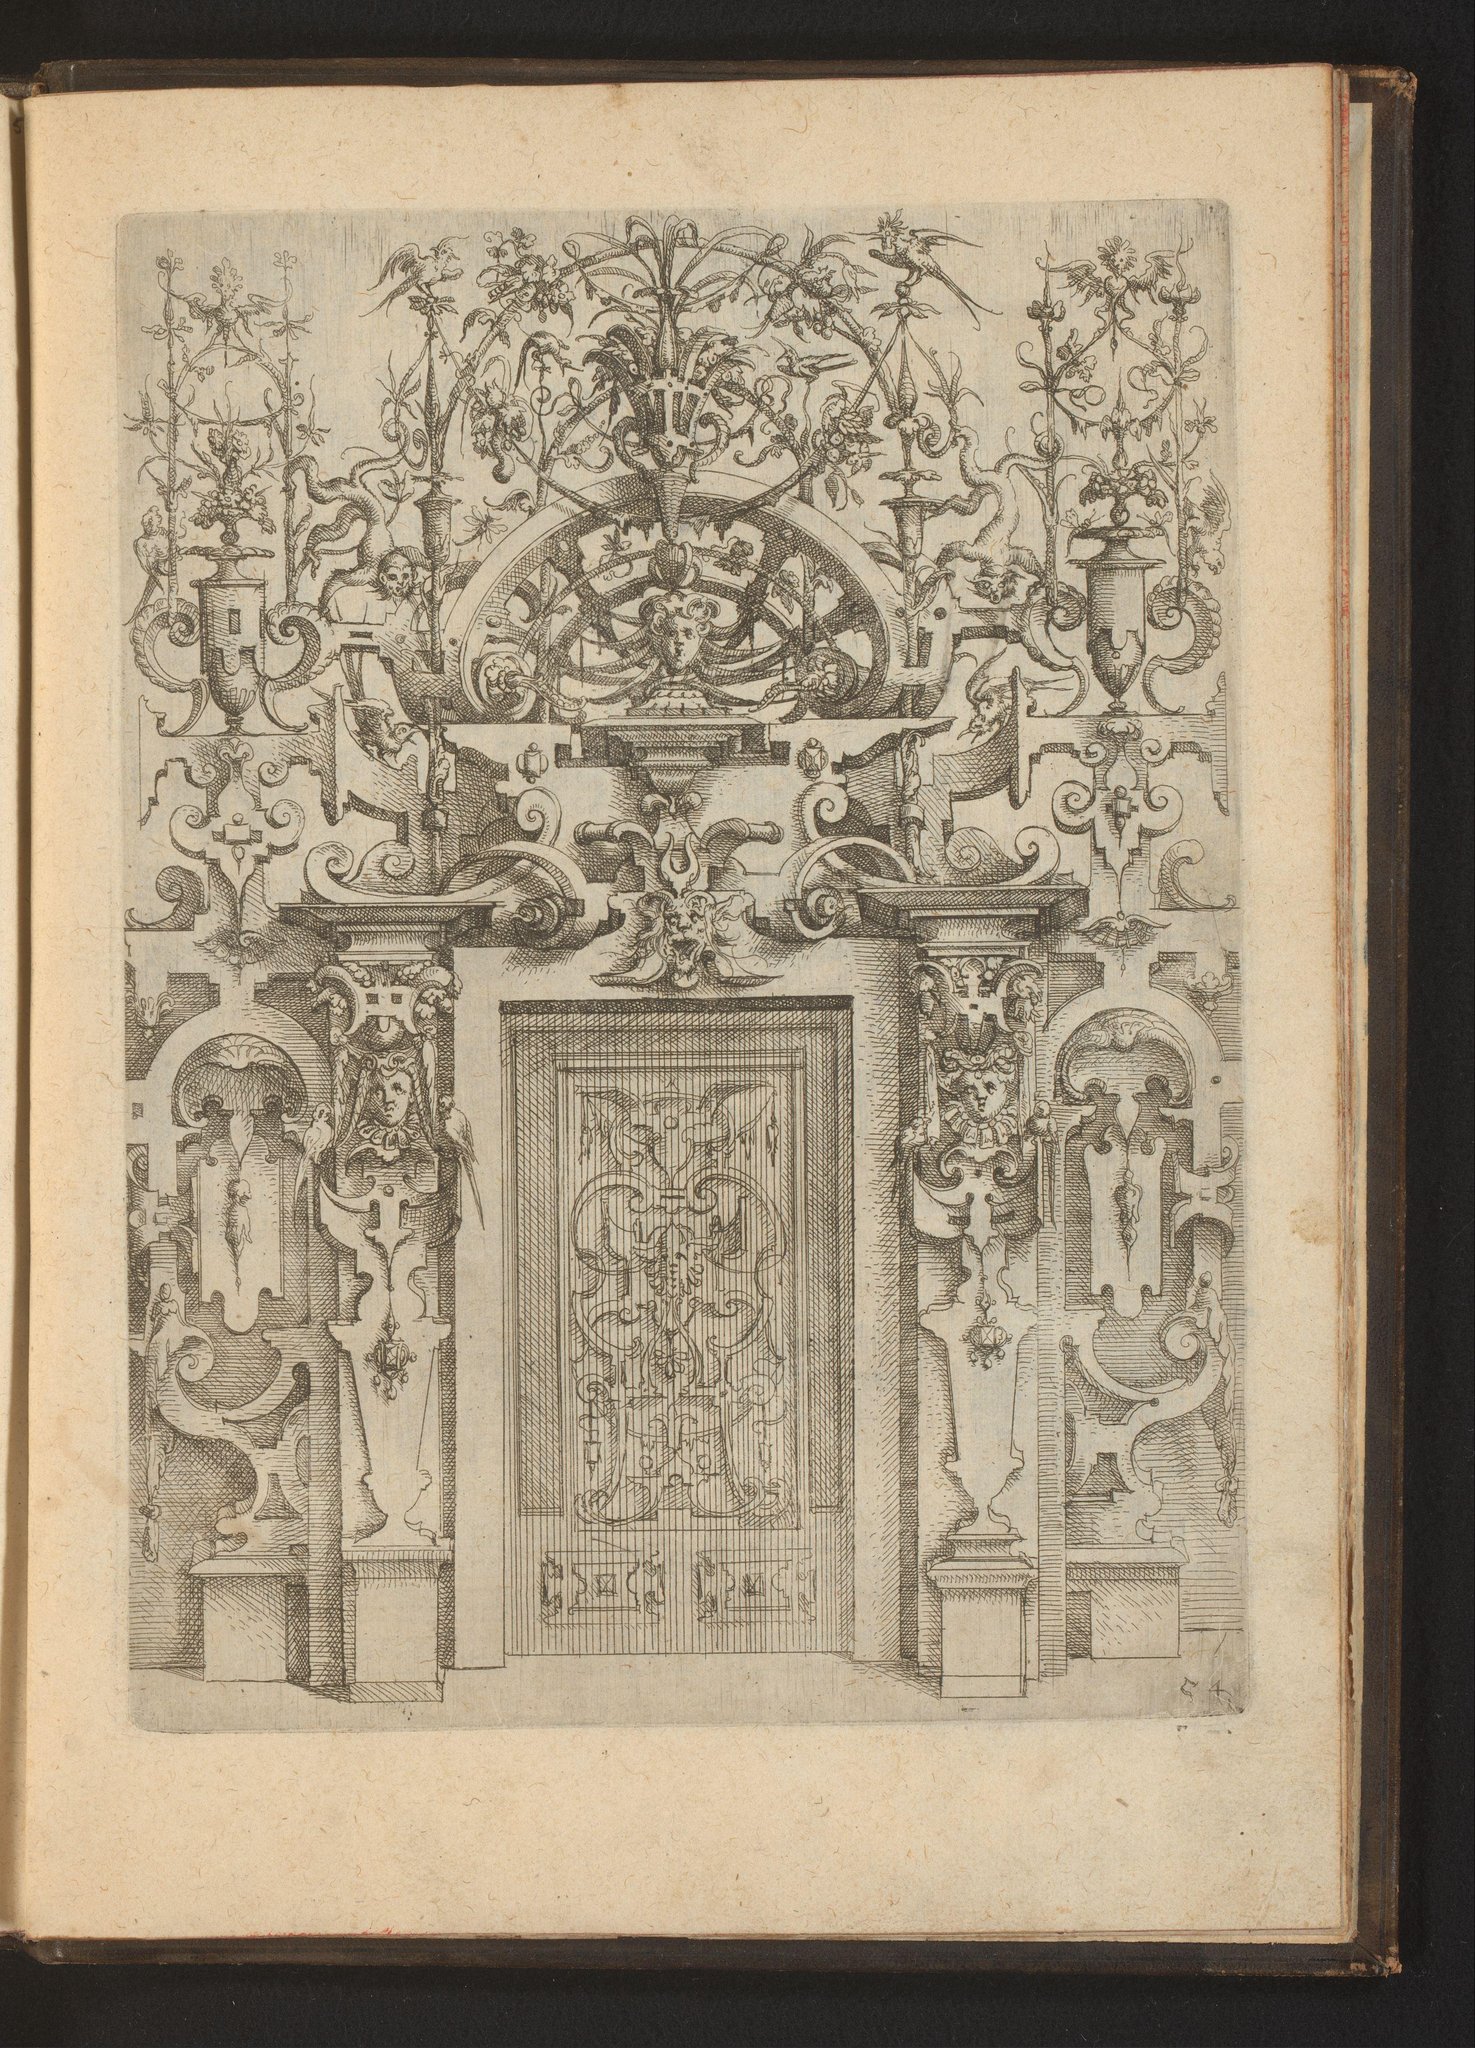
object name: ornament print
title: Portaal gedecoreerd met mascarons, bladranken en rolwerk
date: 1593-1595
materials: paper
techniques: etching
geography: straatsburg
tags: parts of church exterior and annexes: portal, composite order ~ architecture, 'laub- und bandelwerk' ~ ornament, mask, mascaron ~ ornament, ornament derived from architectural details, ornament ~ festoon, garland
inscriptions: collector's mark: Lugt 2228, collector's mark: Lugt 2760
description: Prent gebruikt in: Dietterlin, Wendel (I). Wendel Dietterlin, Architectura de Polstium seu Portalium ornatu uario Liber II. Straatsburg: Bernhard Jobin, 1594.